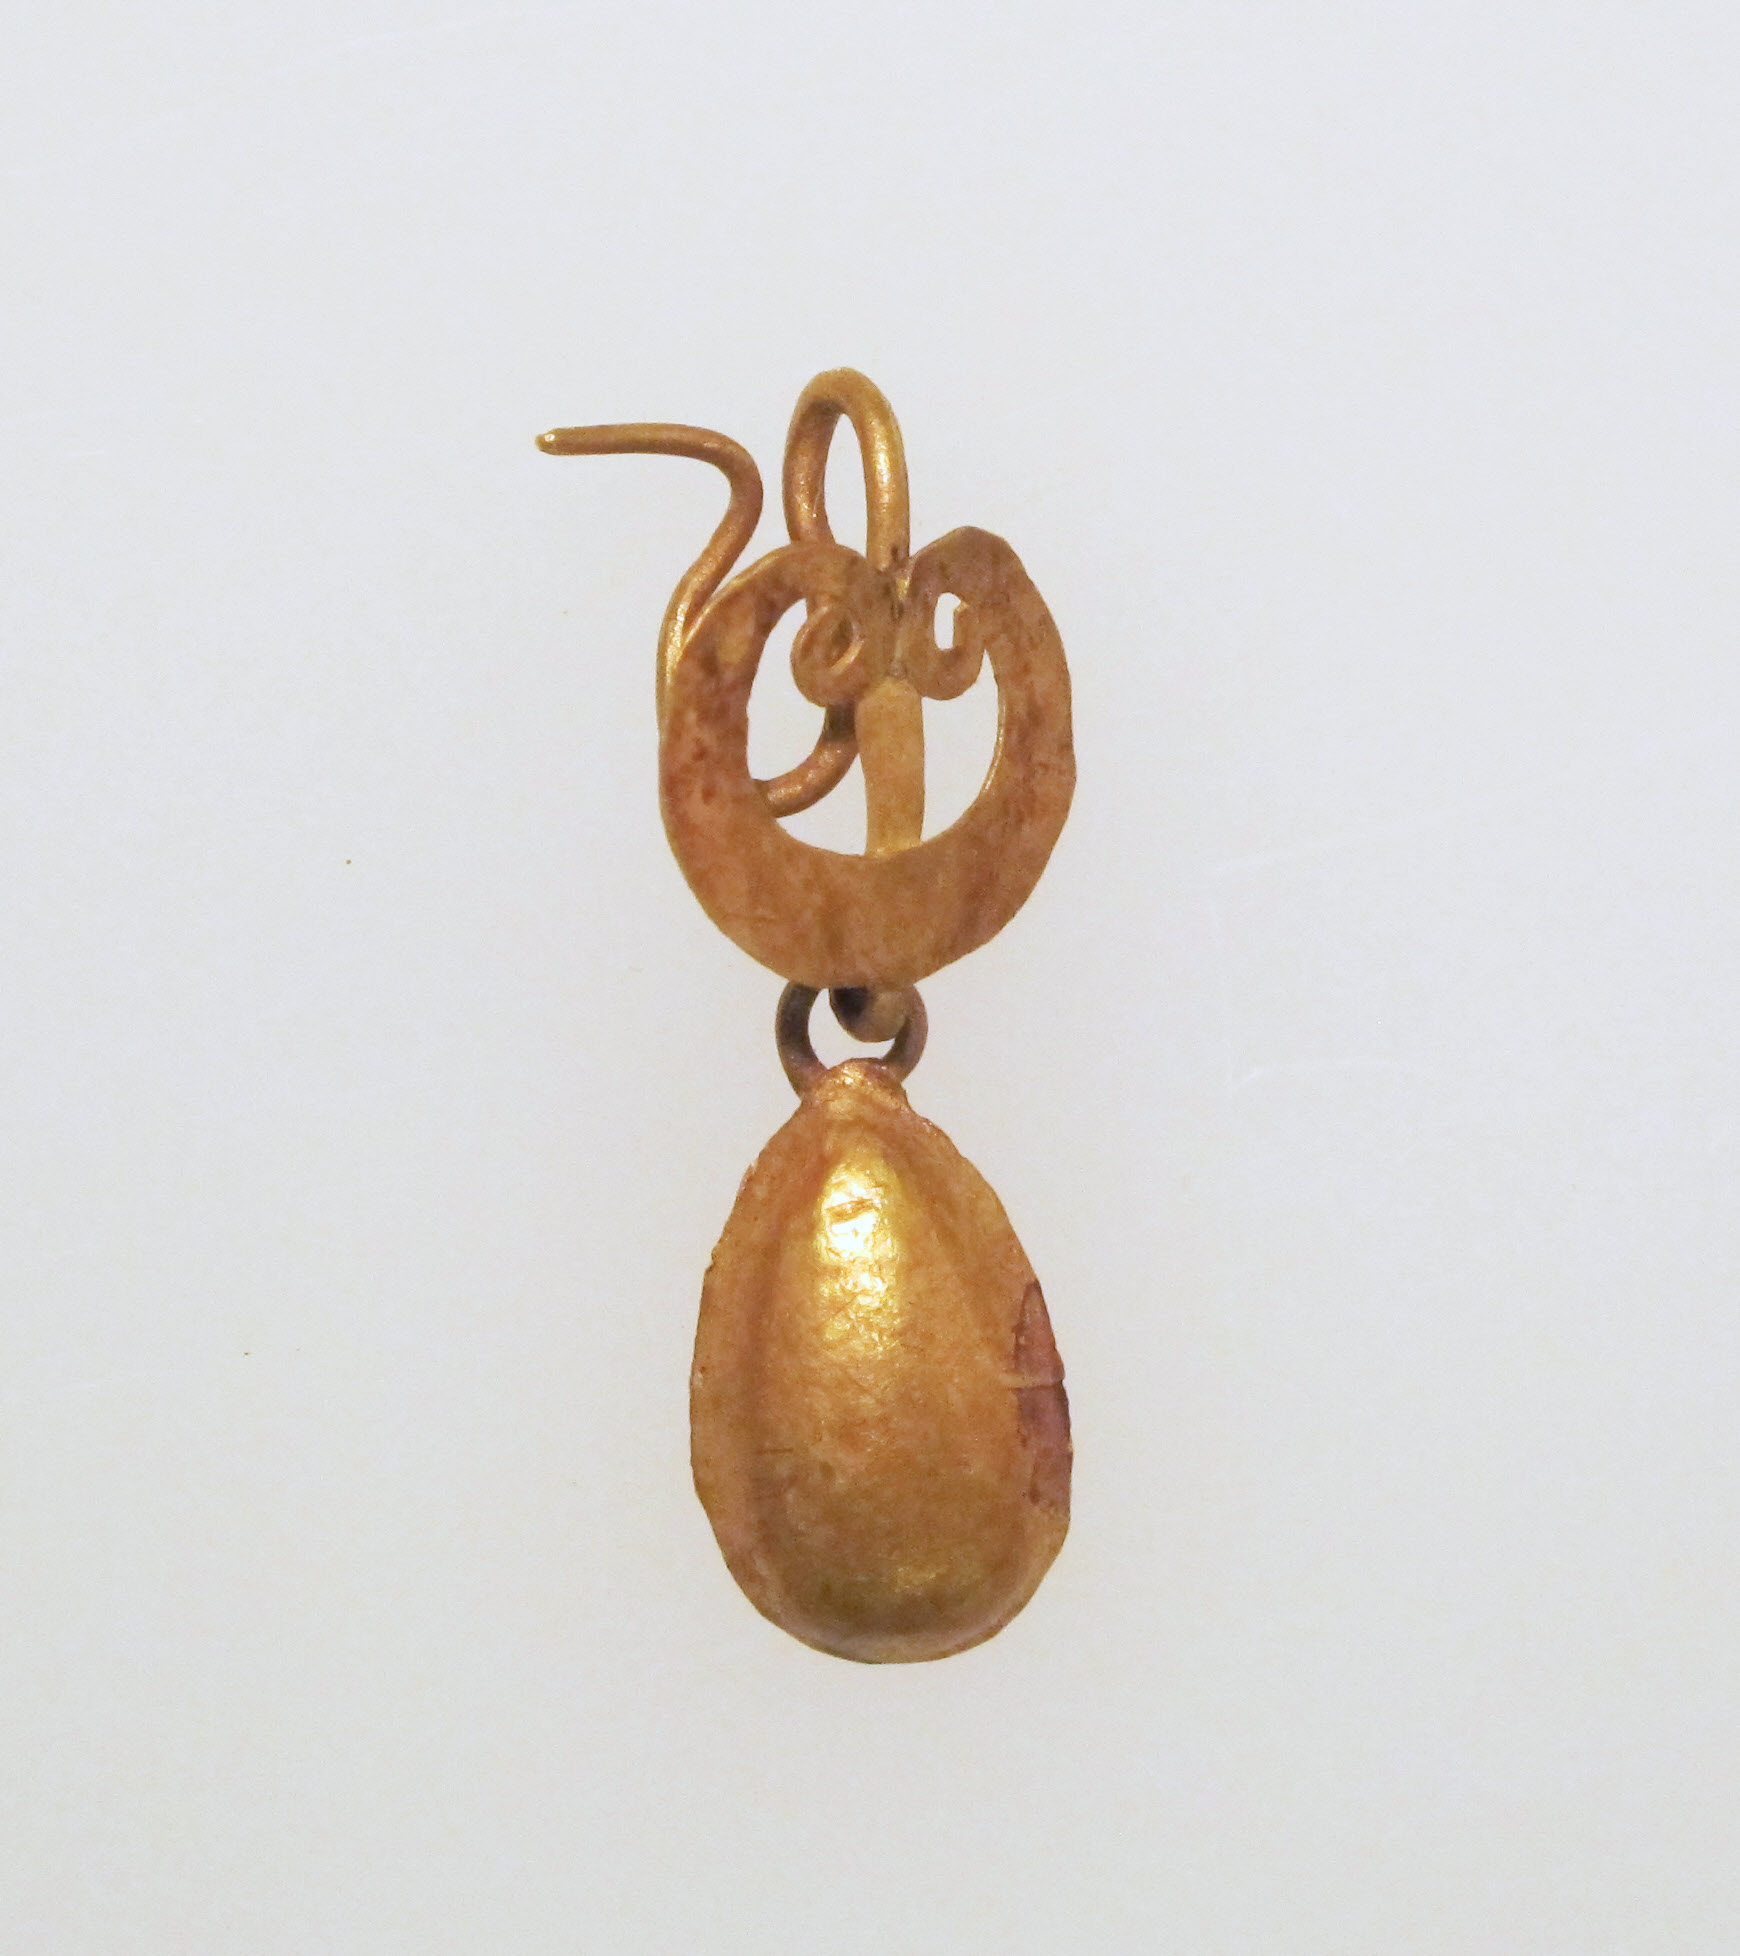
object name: earring hook type with pendant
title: Earring-hook type with pendant and disc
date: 7000 BCE-330 CE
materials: gold